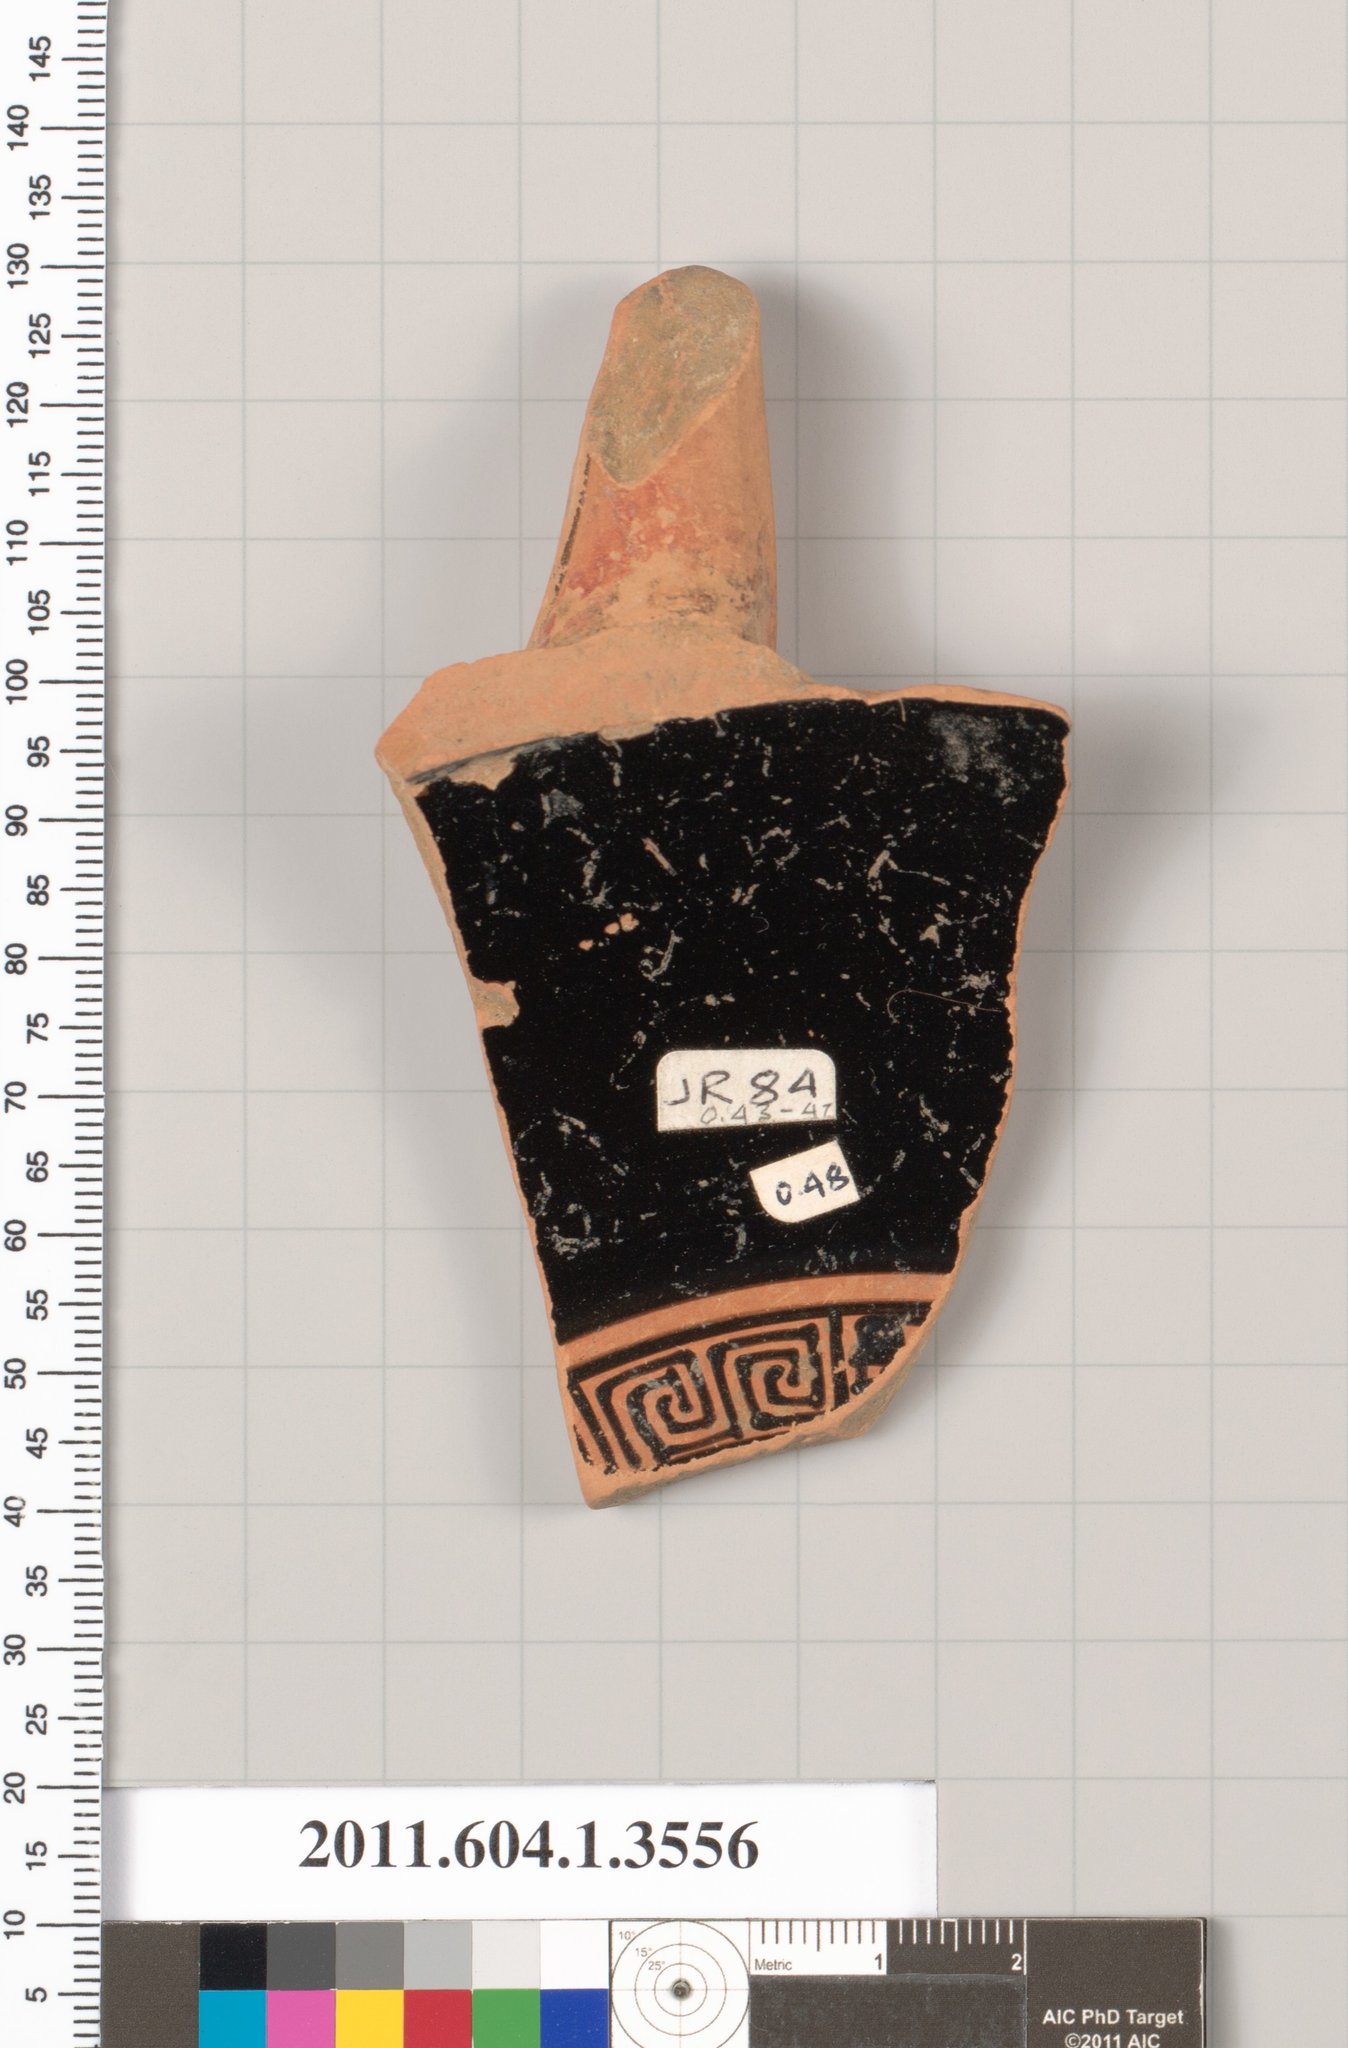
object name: kylix fragment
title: Terracotta fragment of a kylix (drinking cup)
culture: greek, attic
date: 475-451 BCE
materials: terracotta